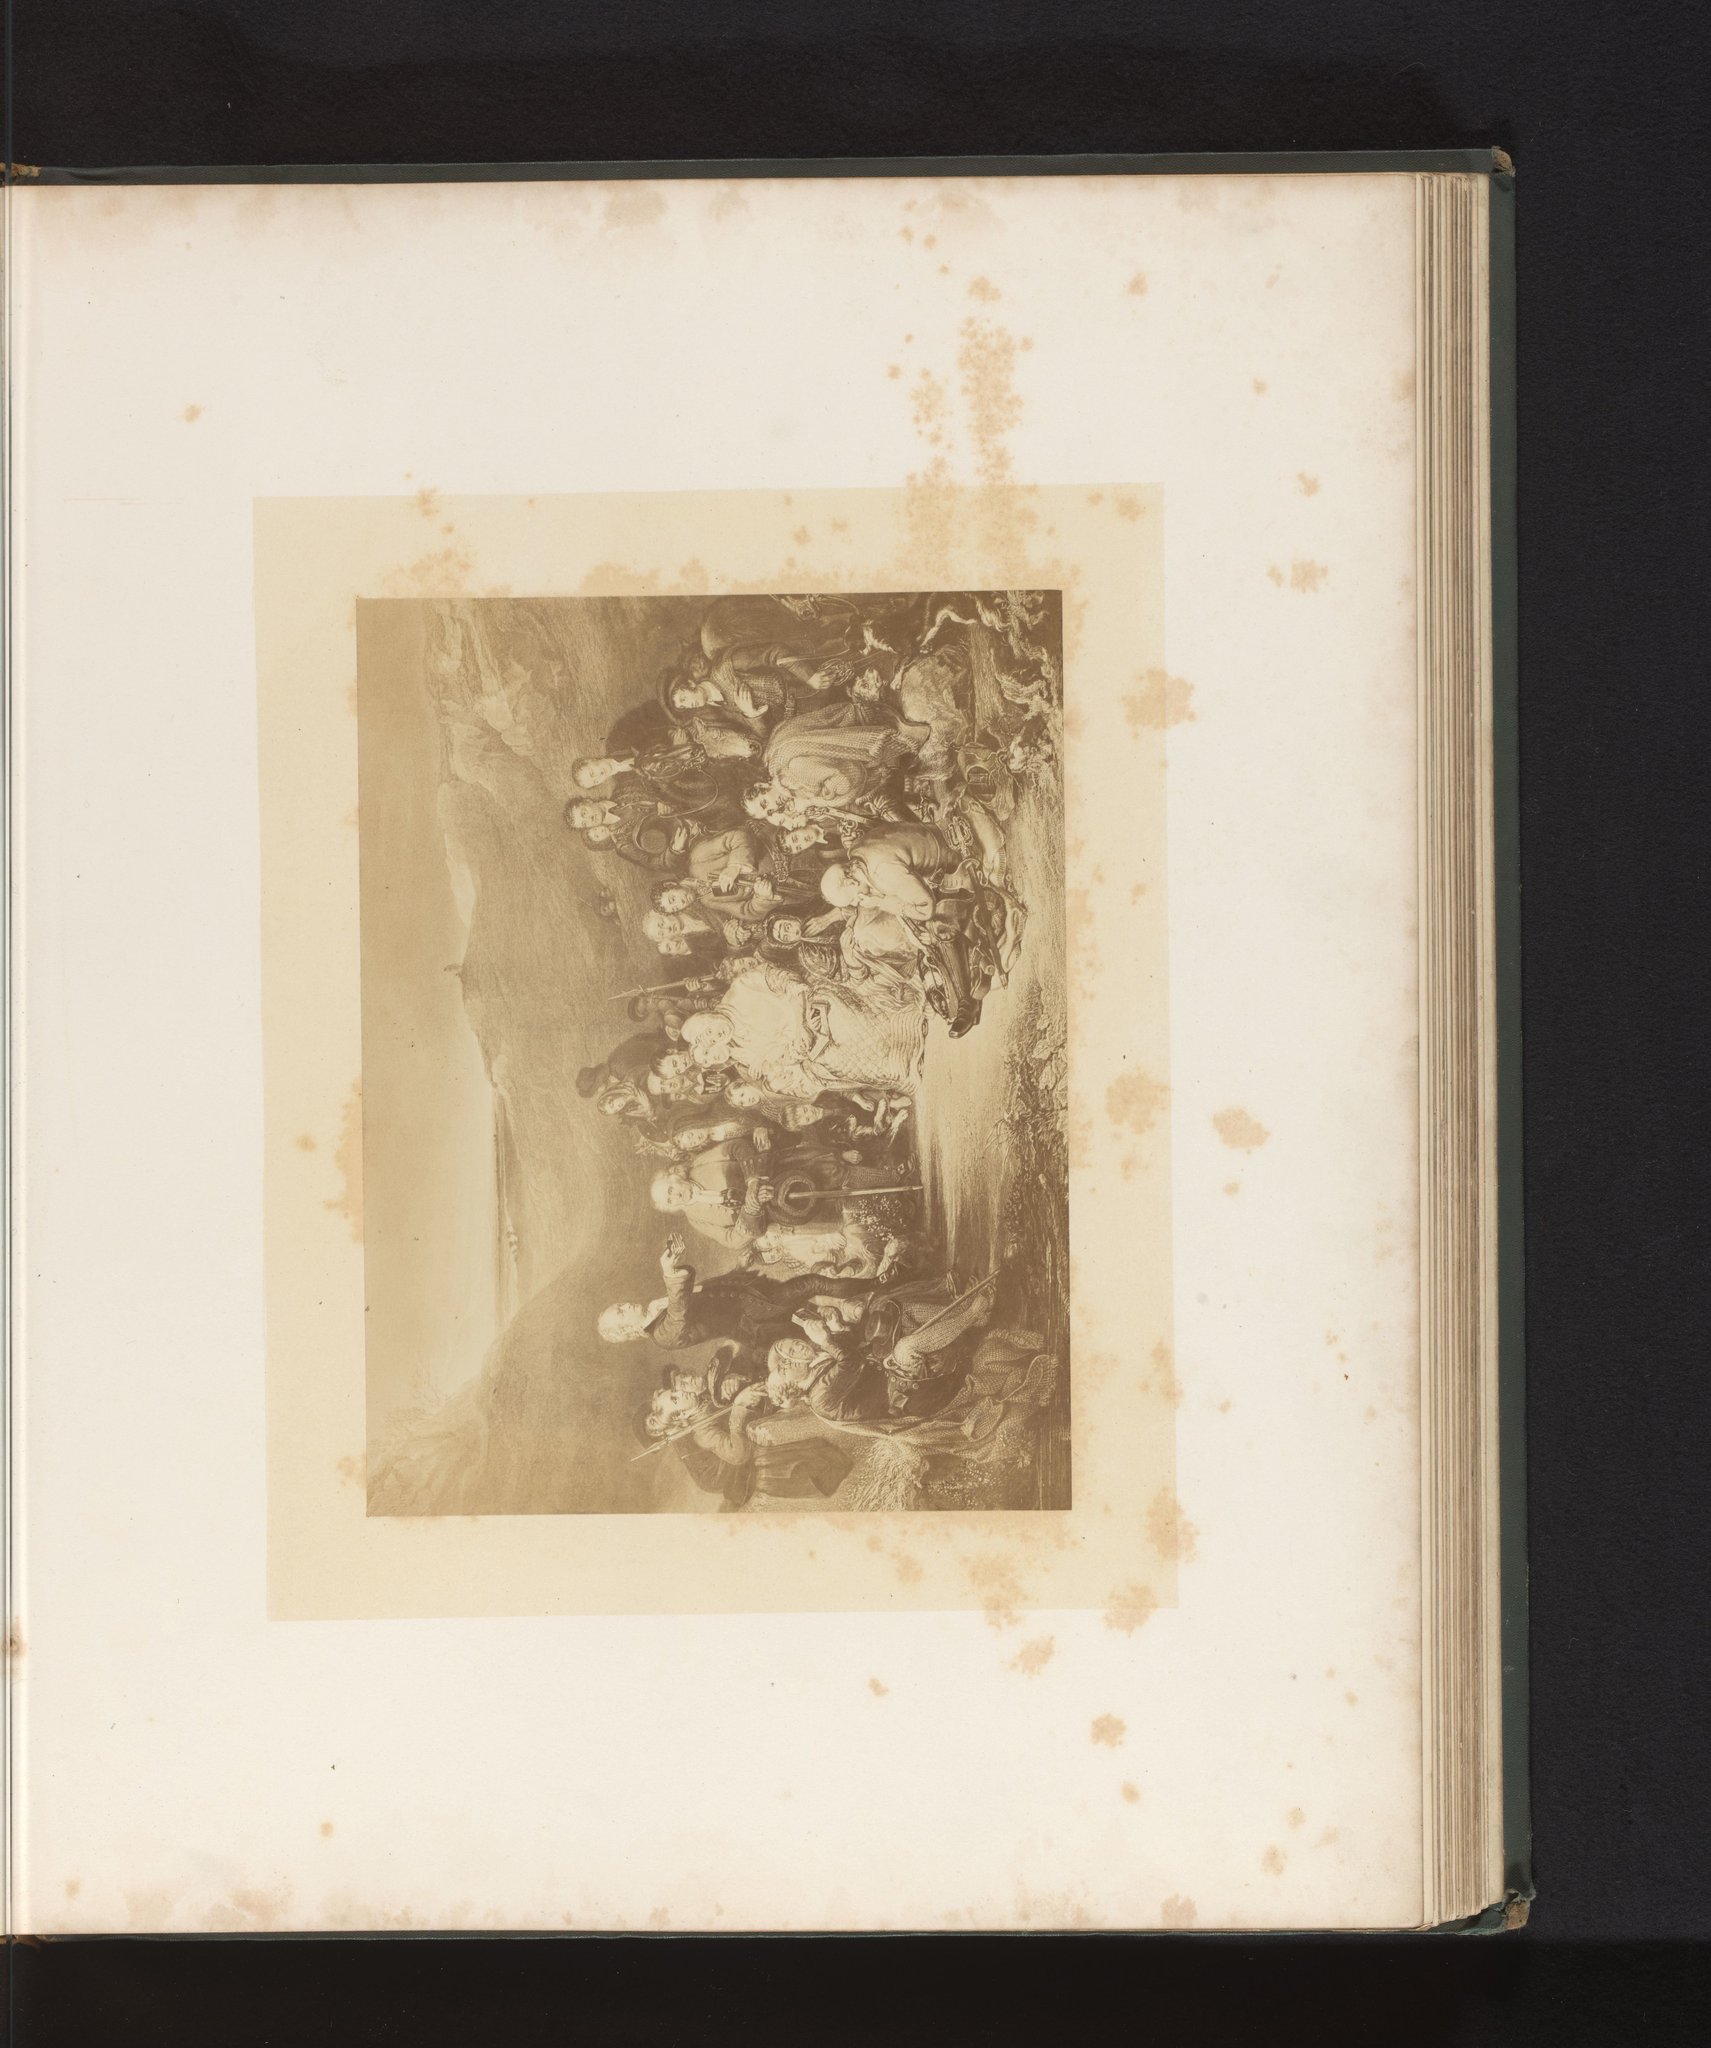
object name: reproduction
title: Fotoreproductie van een gravure van Convenanters Preaching, naar het schilderij door Sir George Harvey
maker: thomas annan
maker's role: fotograaf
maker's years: 1829-1887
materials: photographic support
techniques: albumen print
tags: meeting, assembly, preaching (in general)